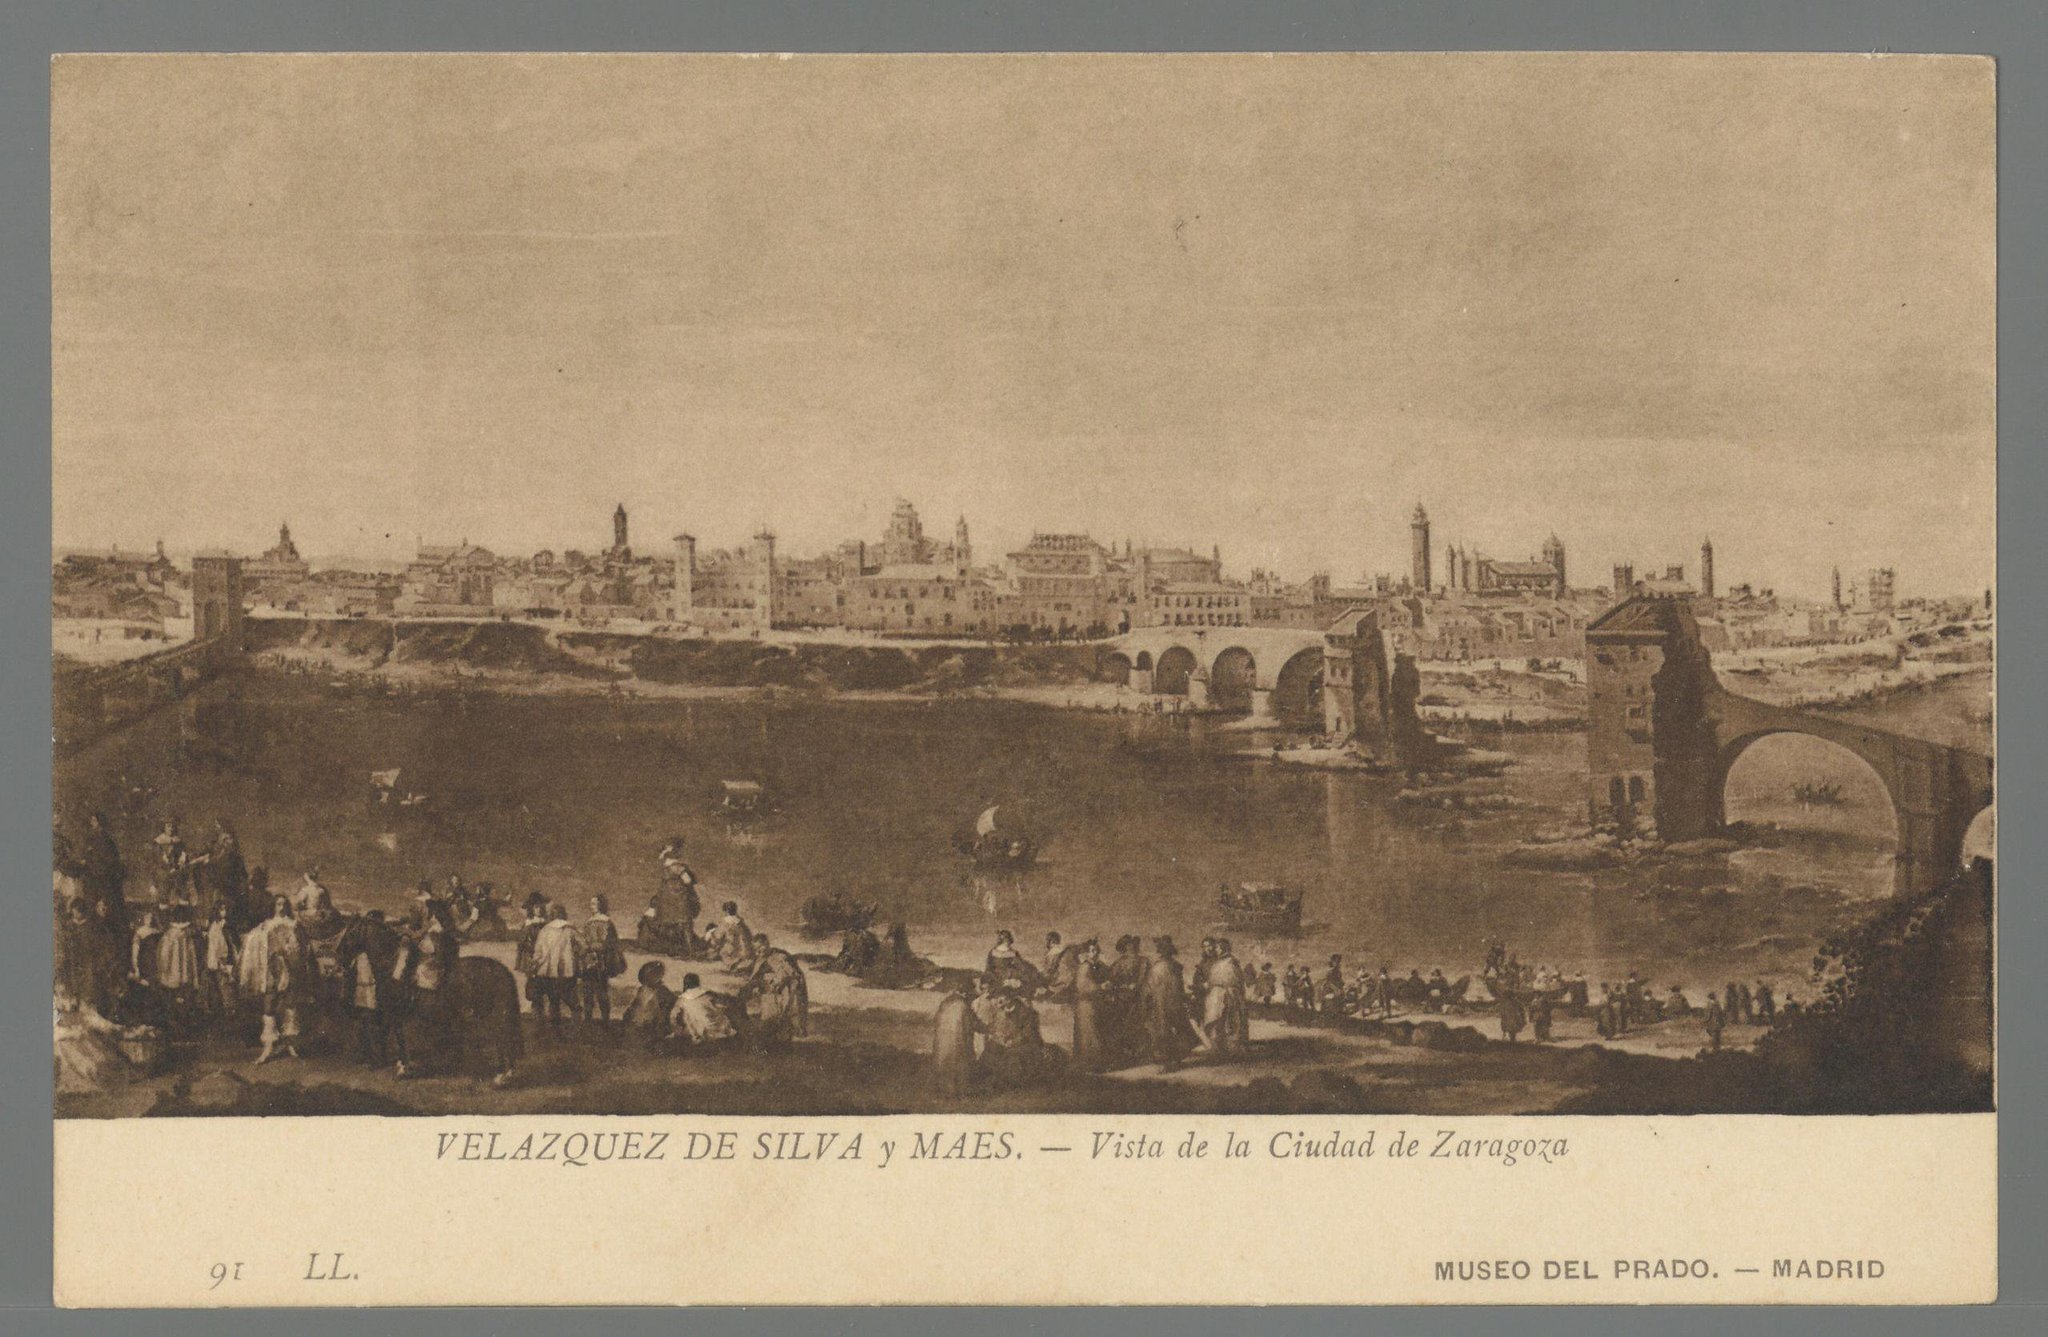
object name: ansichtkaart, prentbriefkaart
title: Vista de la Ciudad de Zaragoza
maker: diego rodriguez de silva y velázquez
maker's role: painter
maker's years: 1599-1660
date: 1905-1920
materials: cardboard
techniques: photograph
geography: madrid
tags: river, prospect of city, town panorama, silhouette of city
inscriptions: stamp: ‘M. Palomeque. Arenal, 17. Madrid’, collector's mark: ‘AFE v S’